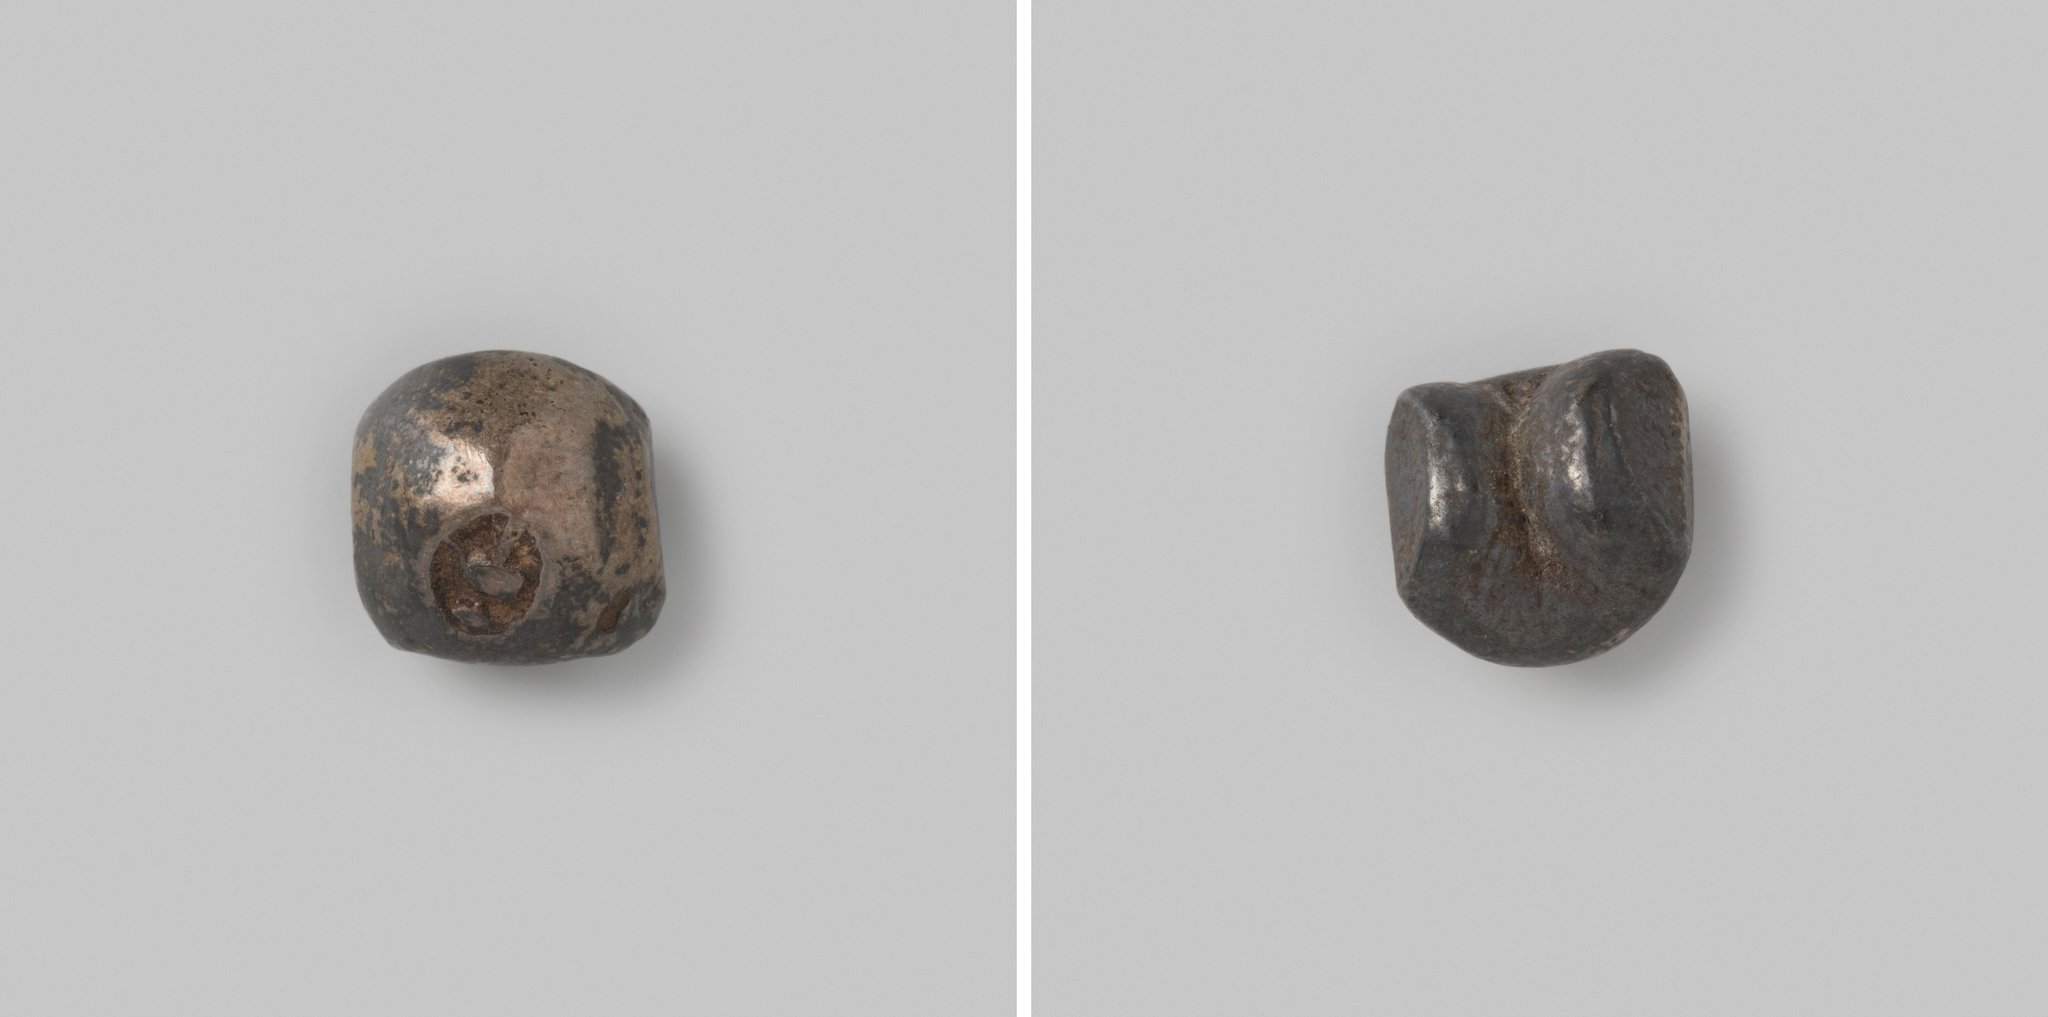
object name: coin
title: 1/4 tical of salung uit Thailand,1650-1850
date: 1650-1850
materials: silver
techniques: casting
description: Zilveren, korrelvormige munt. voorzien van één instempeling (kra): water pot